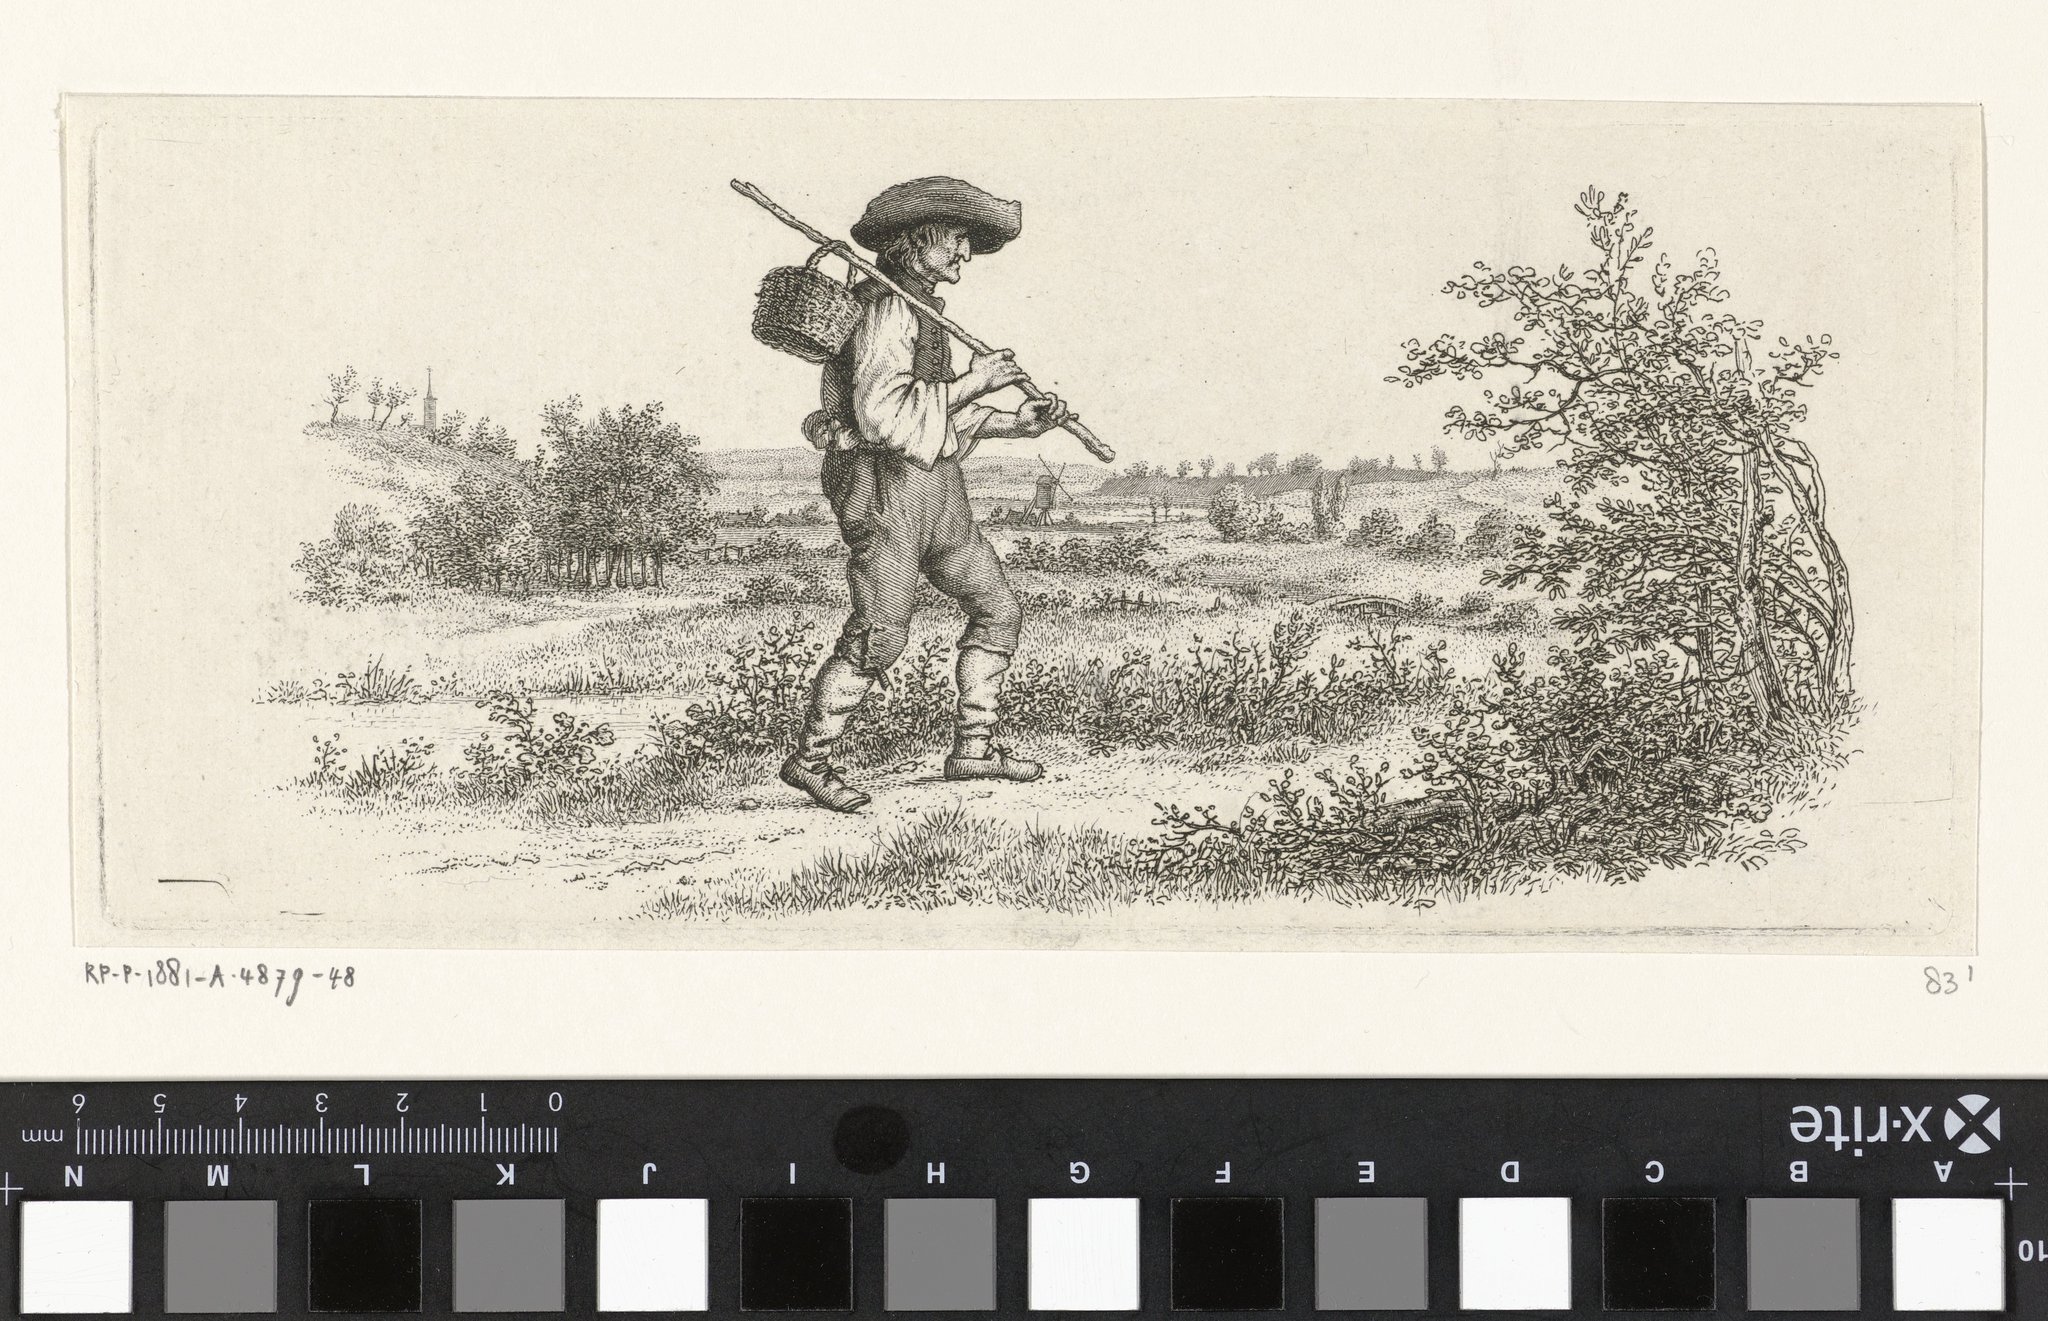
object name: print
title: Man met stok en een mand in een landschap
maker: jacob ernst marcus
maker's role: draughtsman, print maker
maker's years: 1774-1826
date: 1809-1814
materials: paper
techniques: etching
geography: amsterdam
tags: plants (in general) (+ branch, stick), walking (+ right side visible; right - (r. hand, r. foot, etc.)), container made of plant material other than wood: basket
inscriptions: collector's mark: Lugt 2228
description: Serie voor het eerst uitgegeven door Jacob Ernst Marcus onder de titel Studiebeelden en Fragmenten. Amsterdam: ca.1816. Later heruitgegeven als: Studie-prentwerk/ Etudes gravées.